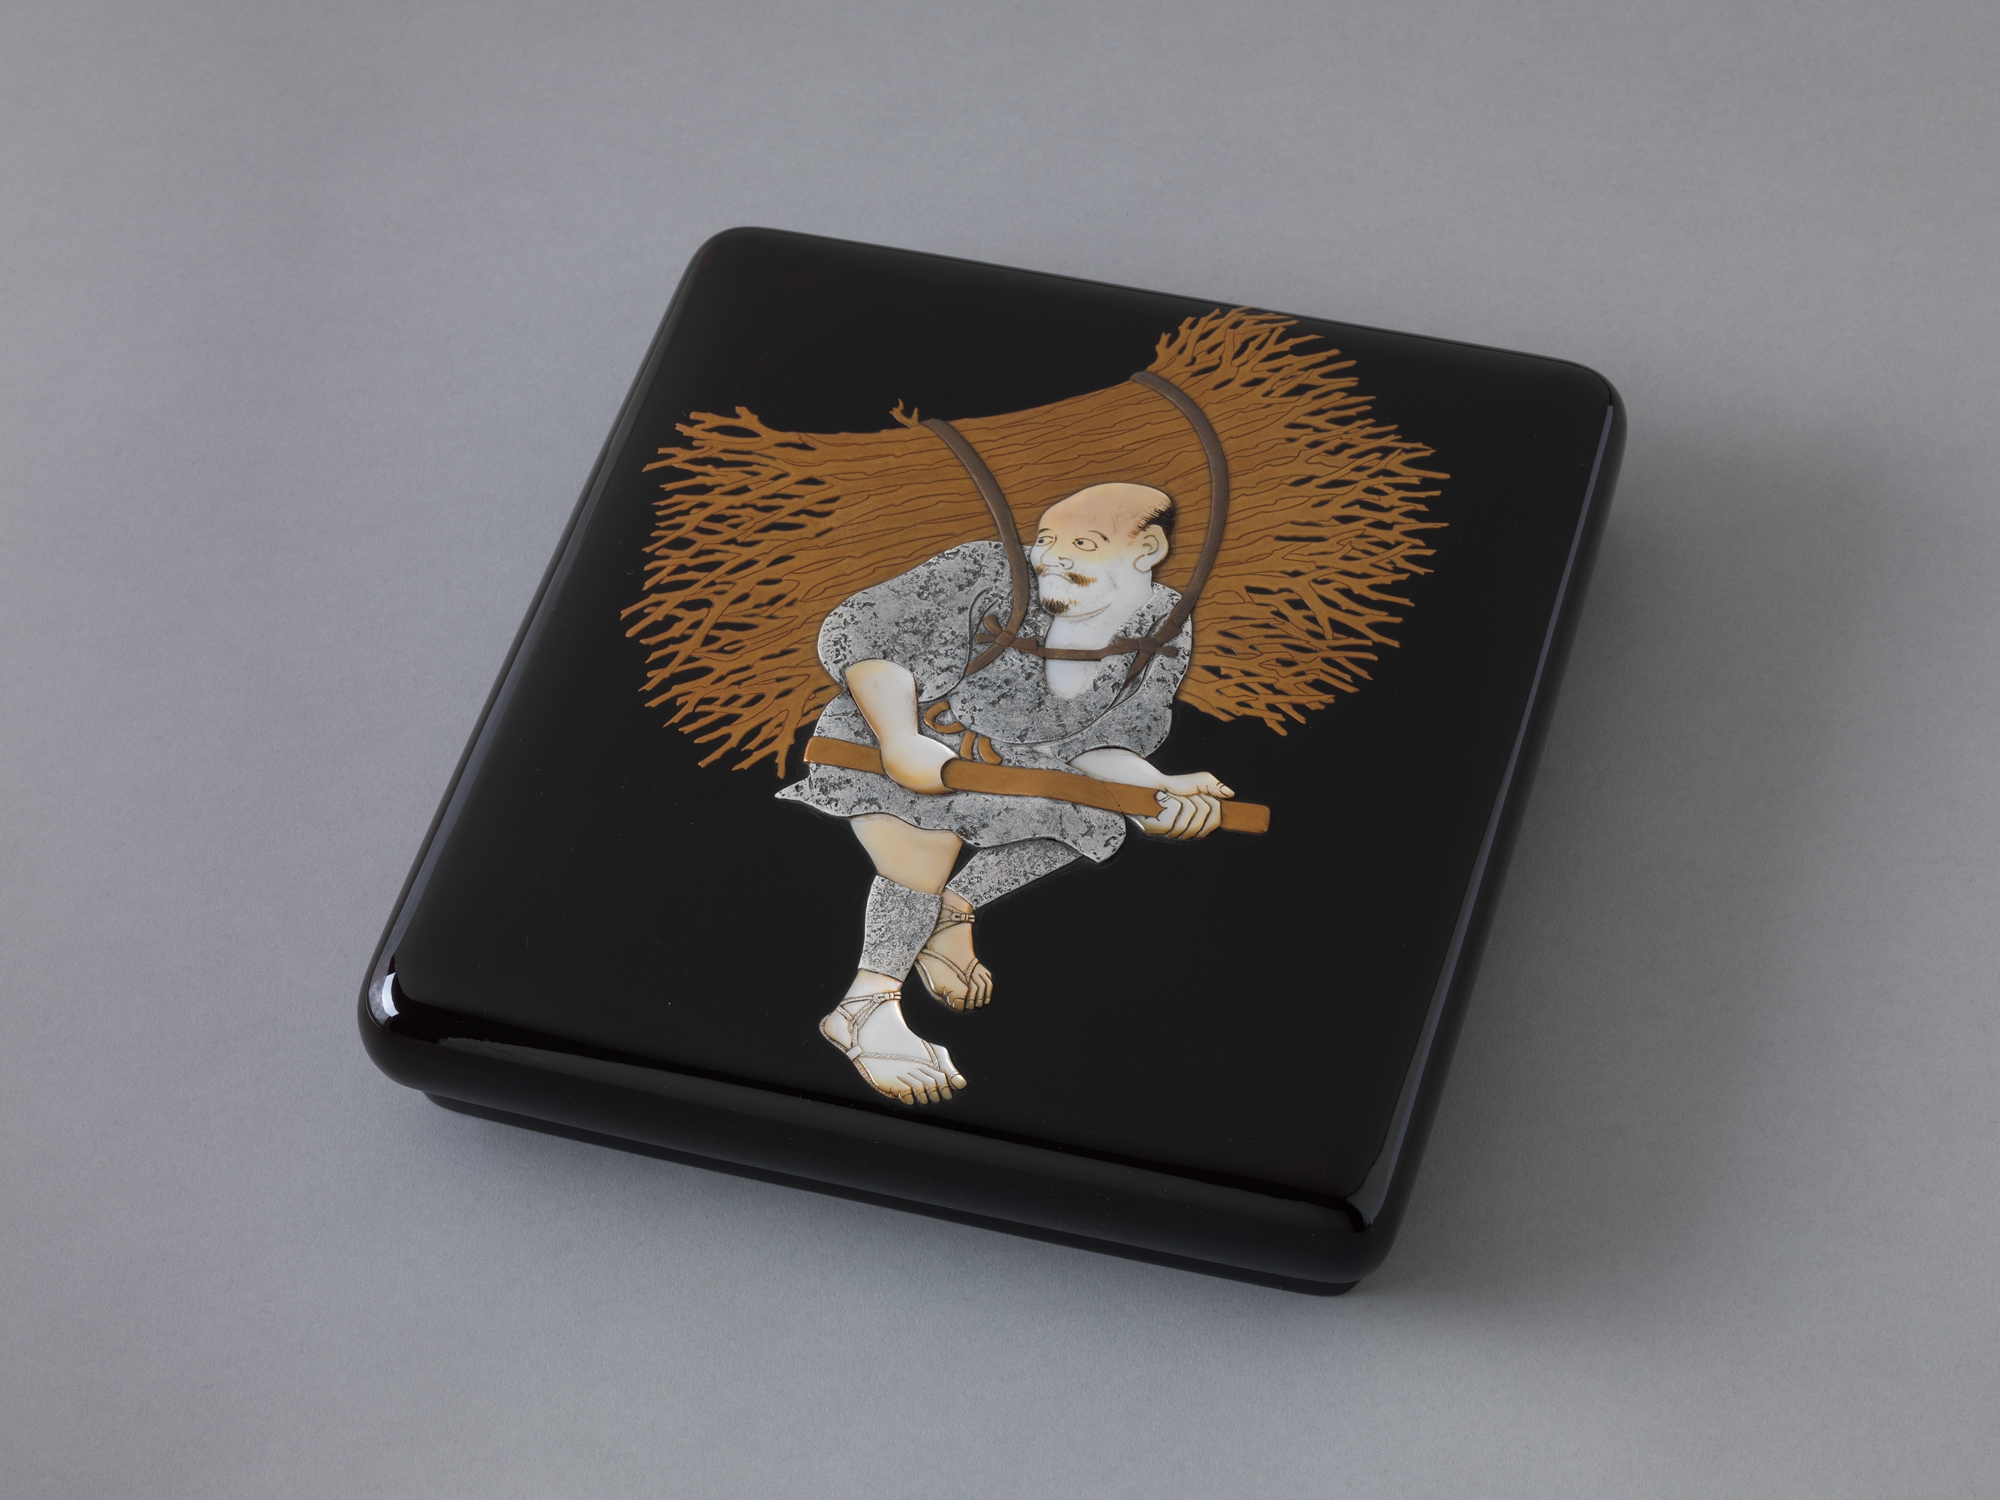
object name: writing box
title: Writing Box (Suzuribako) with Woodcutter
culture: japanese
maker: ogata kōrin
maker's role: artist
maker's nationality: japanese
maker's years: 1658-1716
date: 1801-1900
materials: gold, lacquer, mother of pearl, pewter, wood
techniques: inlay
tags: men